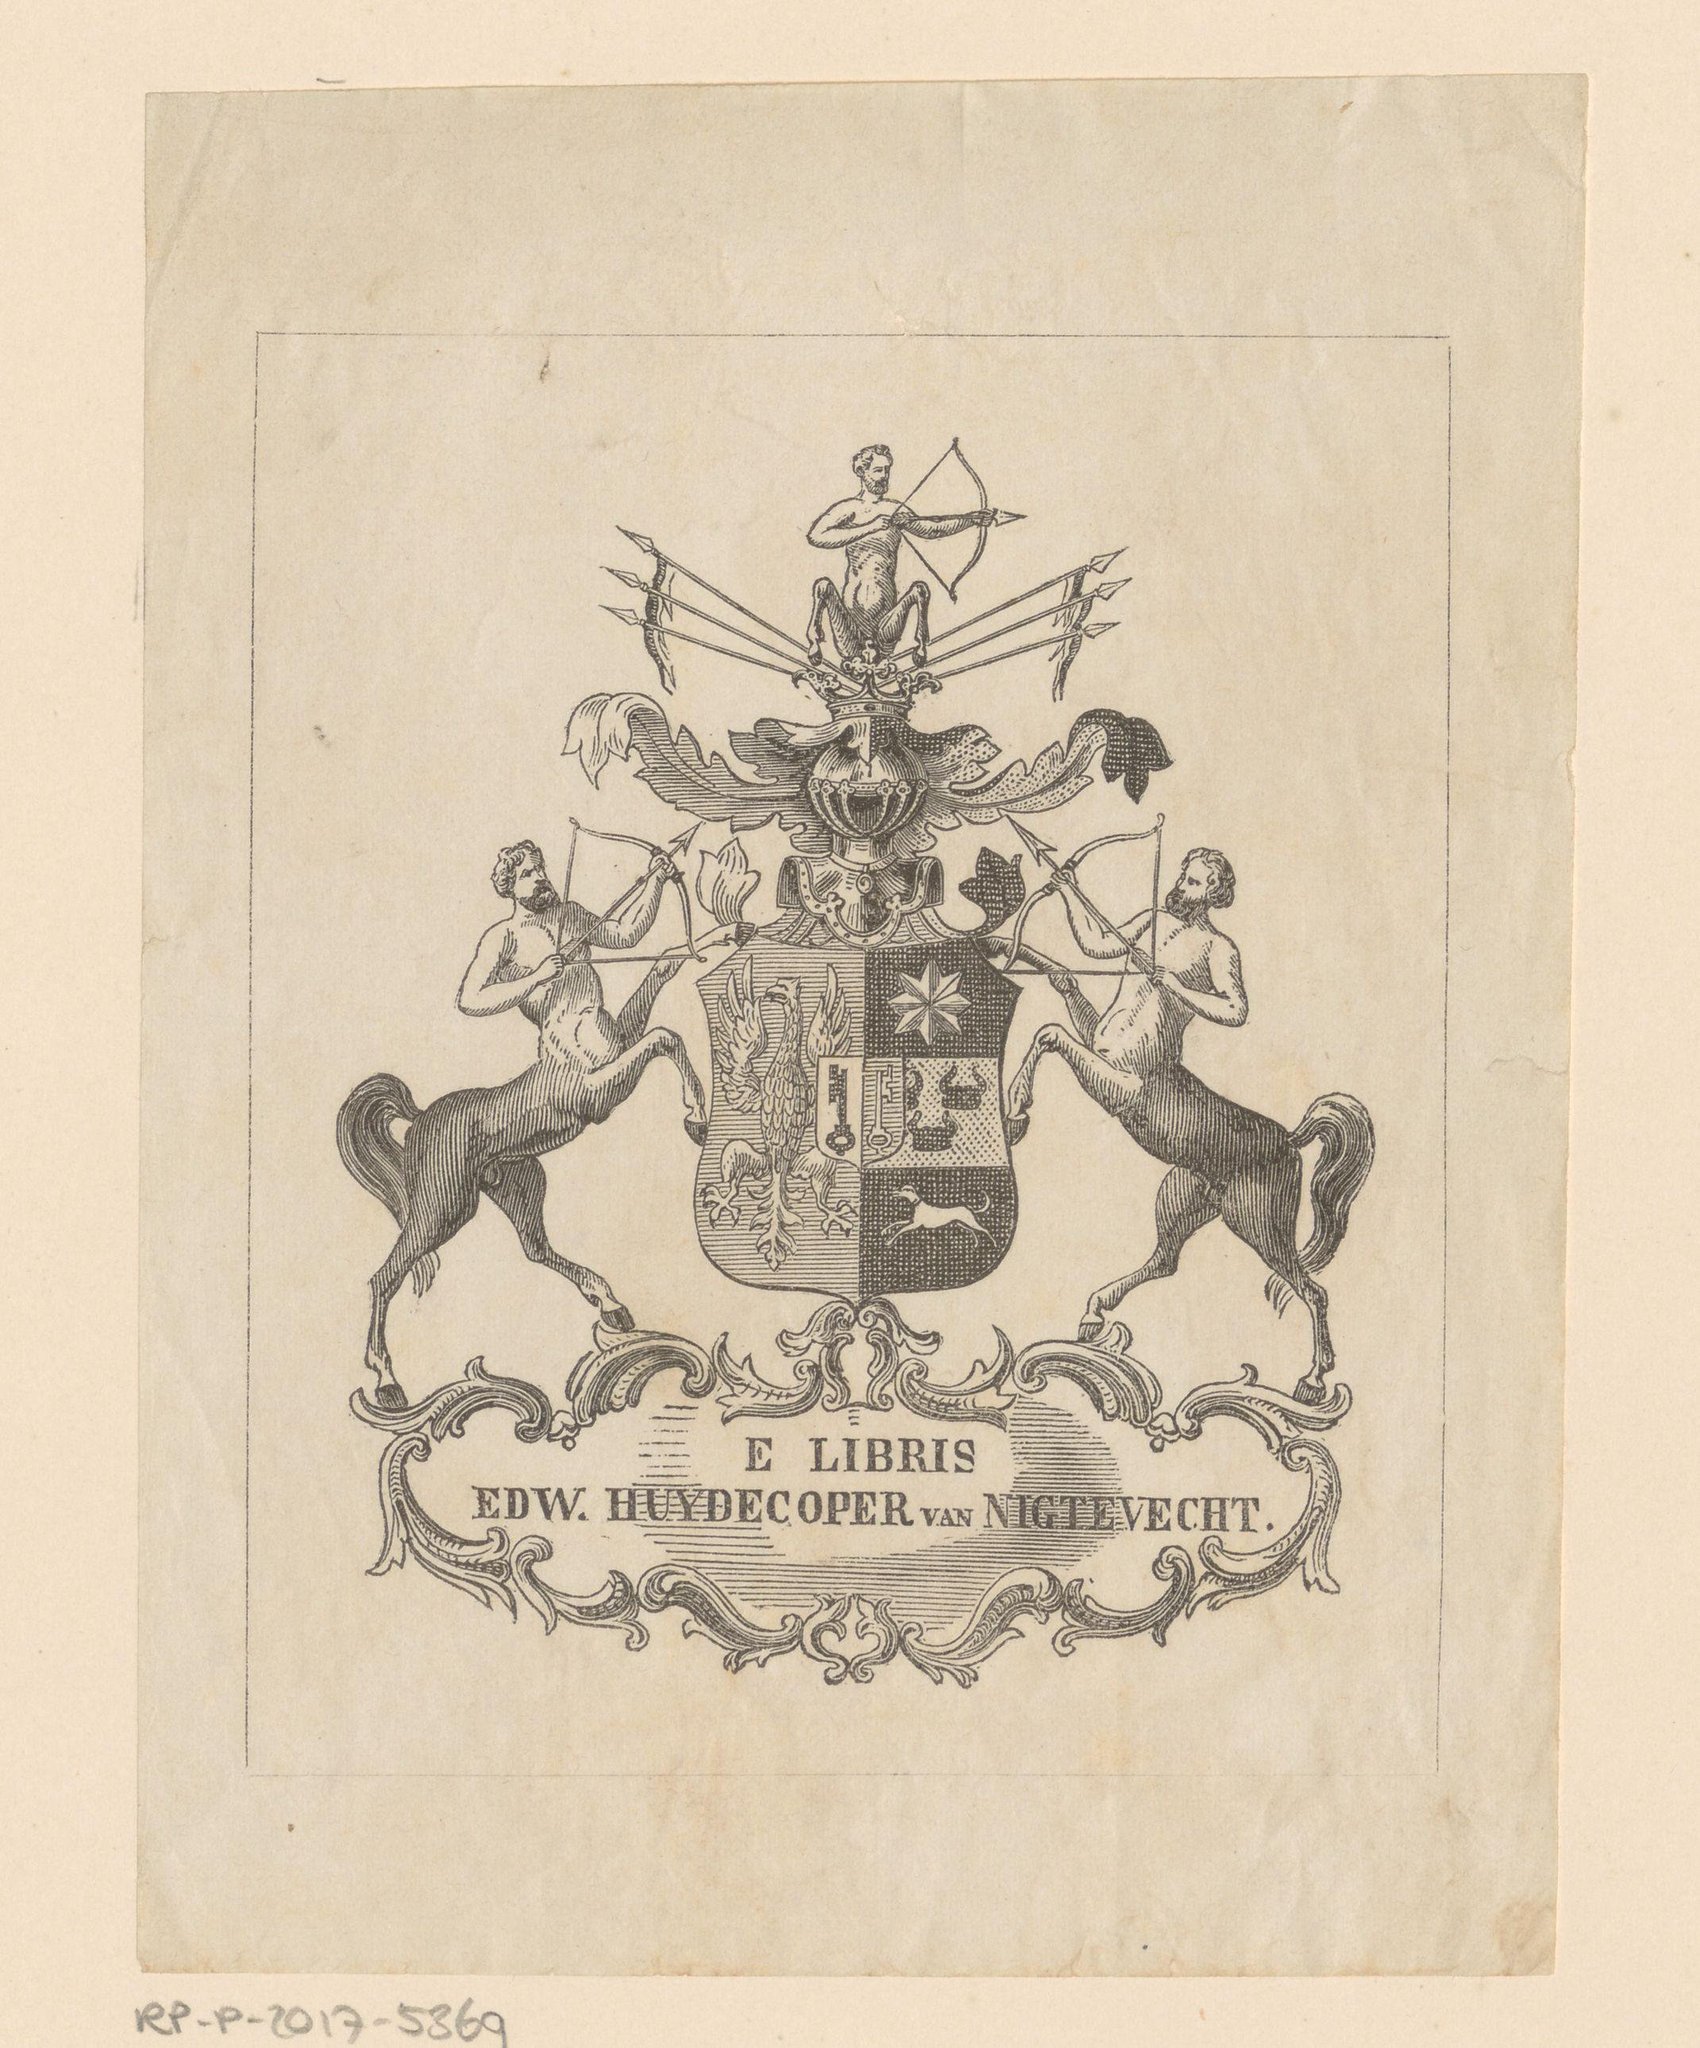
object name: bookplate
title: Ex libris van Edw. Huydecoper van Nigtevecht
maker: Anonymous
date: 1837-1883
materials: paper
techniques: printing block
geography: netherlands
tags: utrecht, edward huydecoper van nigtevecht, centaurs, armorial bearing, heraldry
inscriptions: inscription: ‘Rietstap, 1012.’